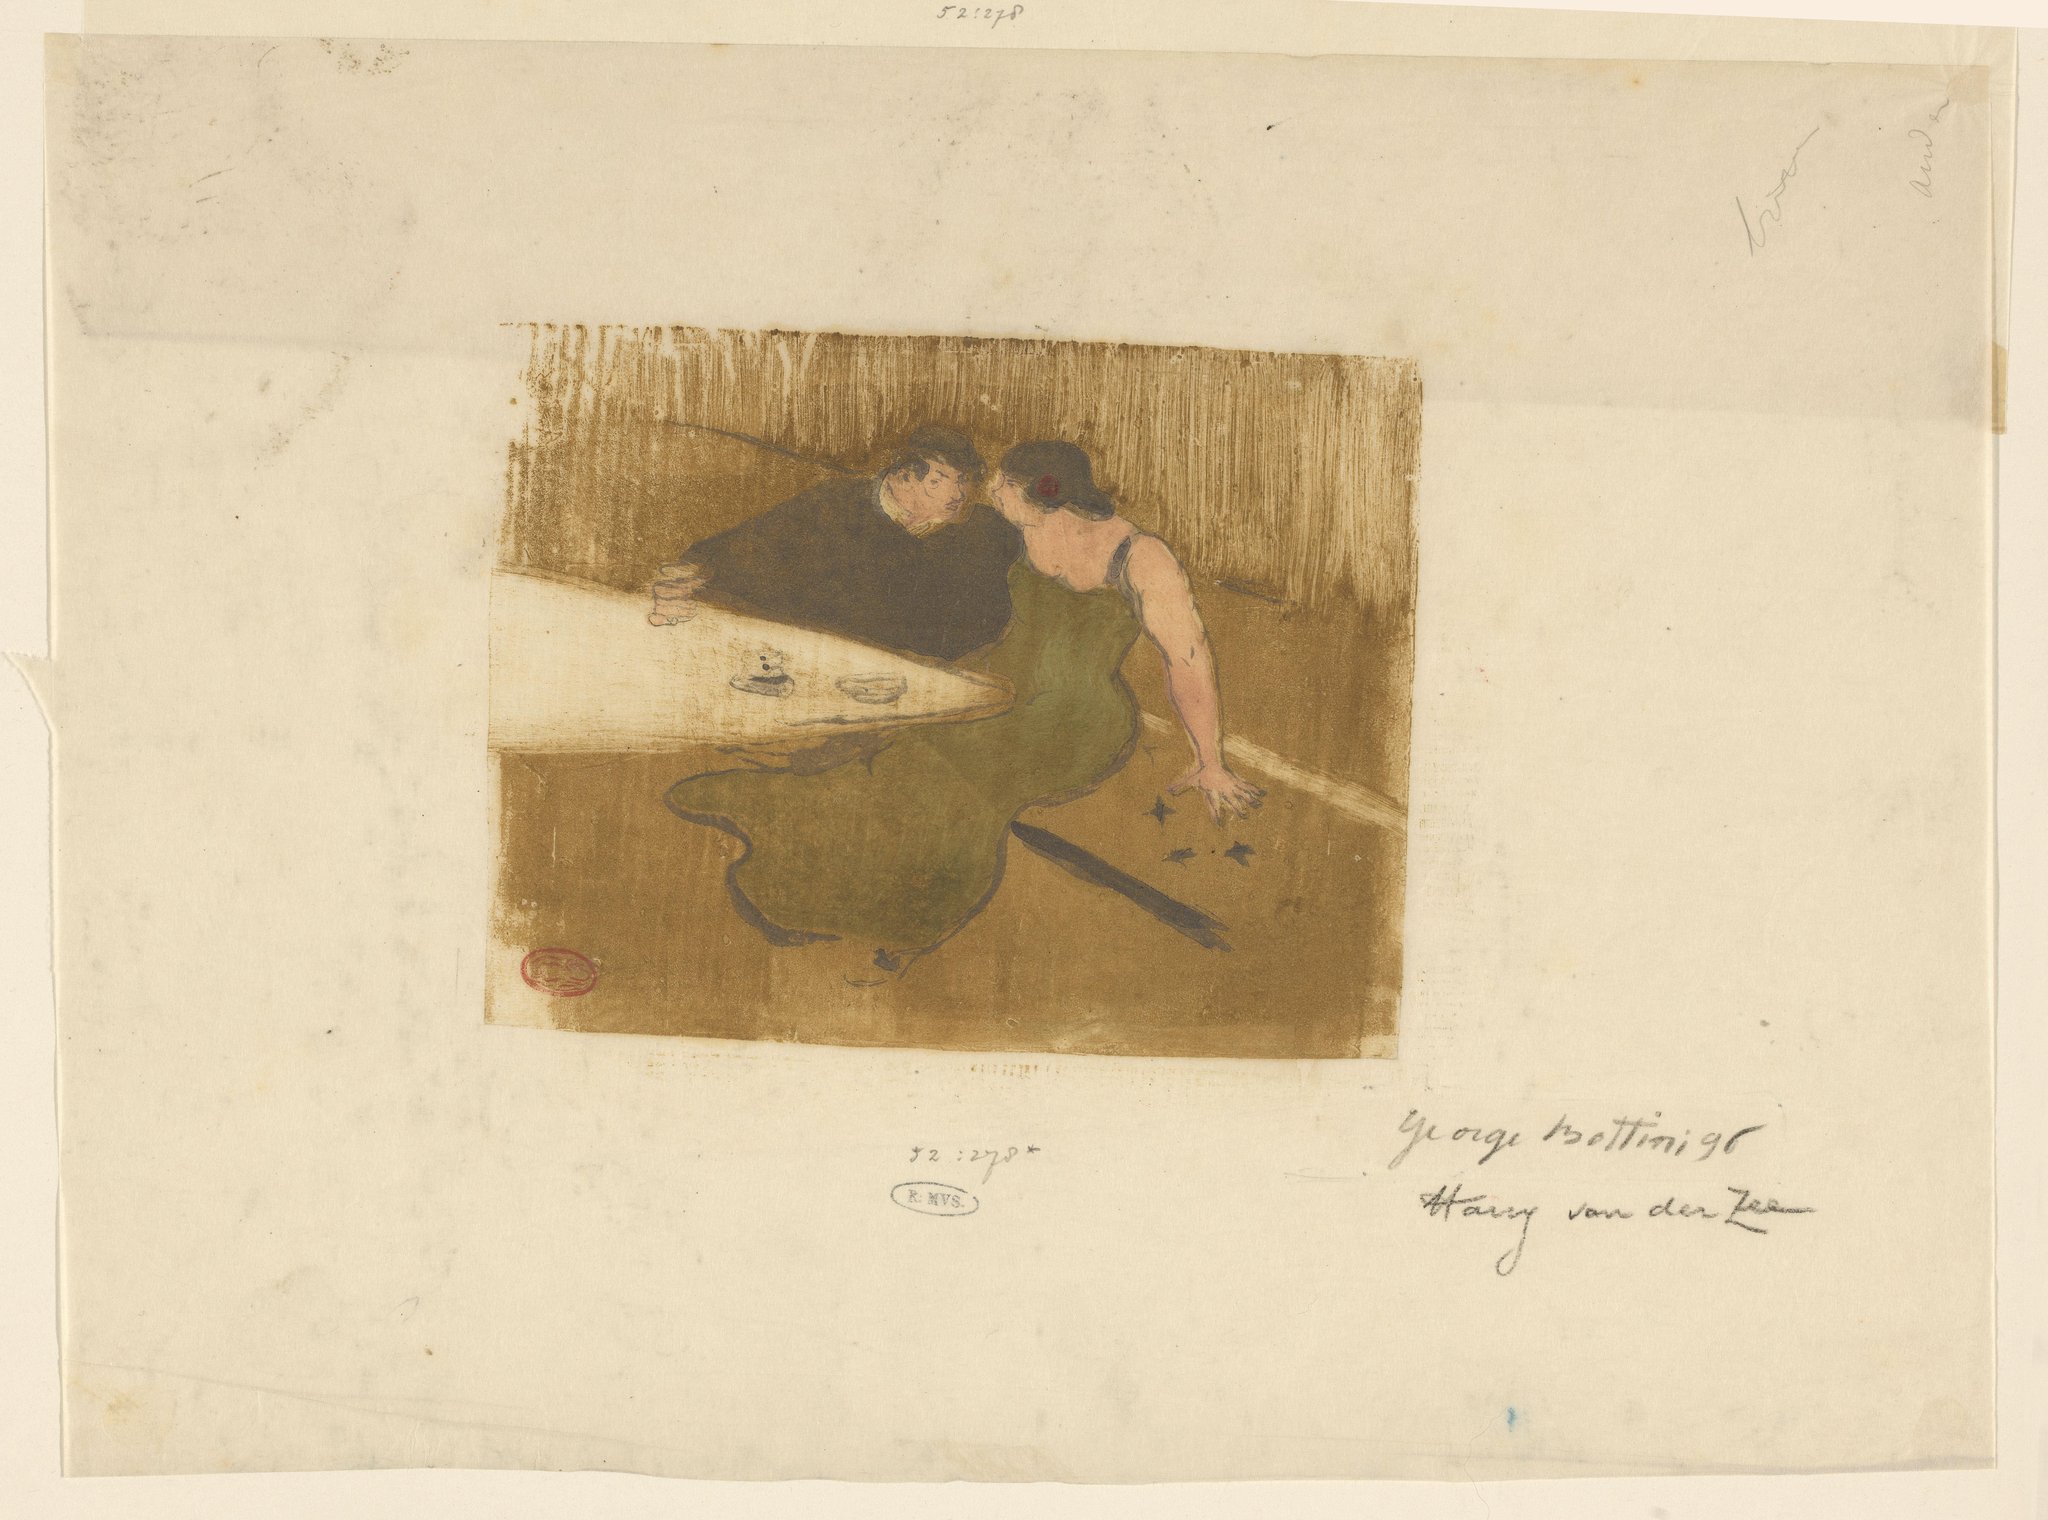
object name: print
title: L'entretien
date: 1896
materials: paper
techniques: woodcut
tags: inn, coffee-house, public house, etc., conversation, dialogue; conversation piece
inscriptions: collector's mark: Lugt 2228, stamp: Lugt 2821